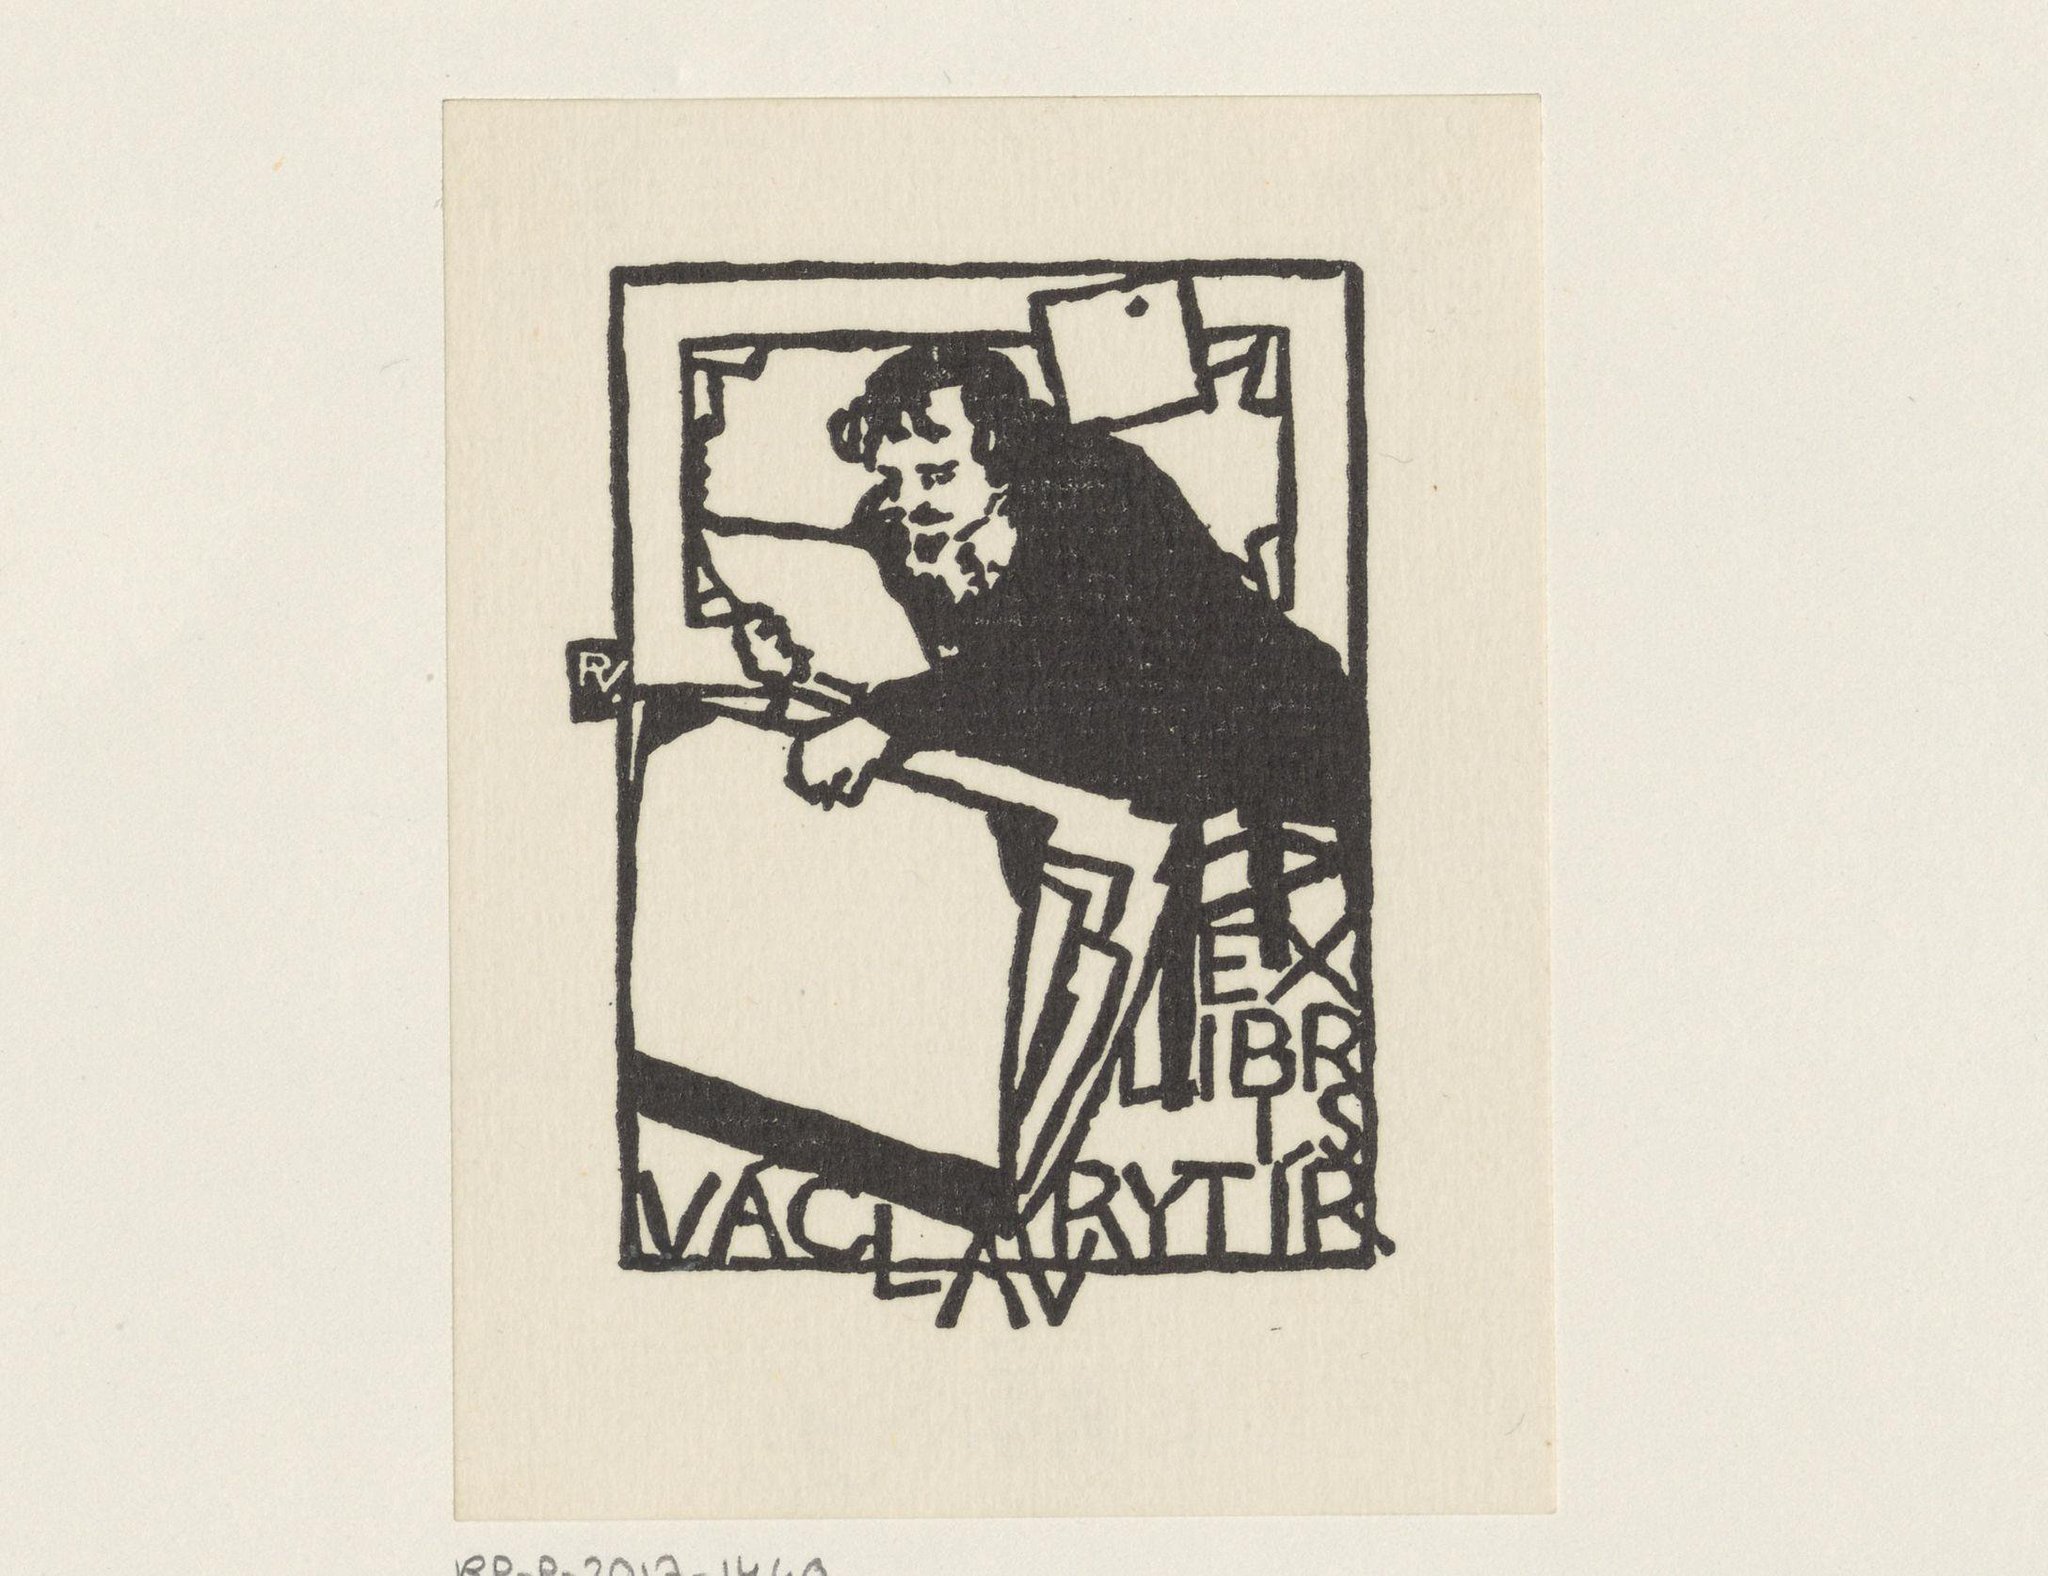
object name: bookplate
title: Ex libris van Václav Rytíř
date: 1909-1943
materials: paper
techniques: printing block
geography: czech republic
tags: prague, václav rytíř, art collector, frame of painting, etc., printed matter